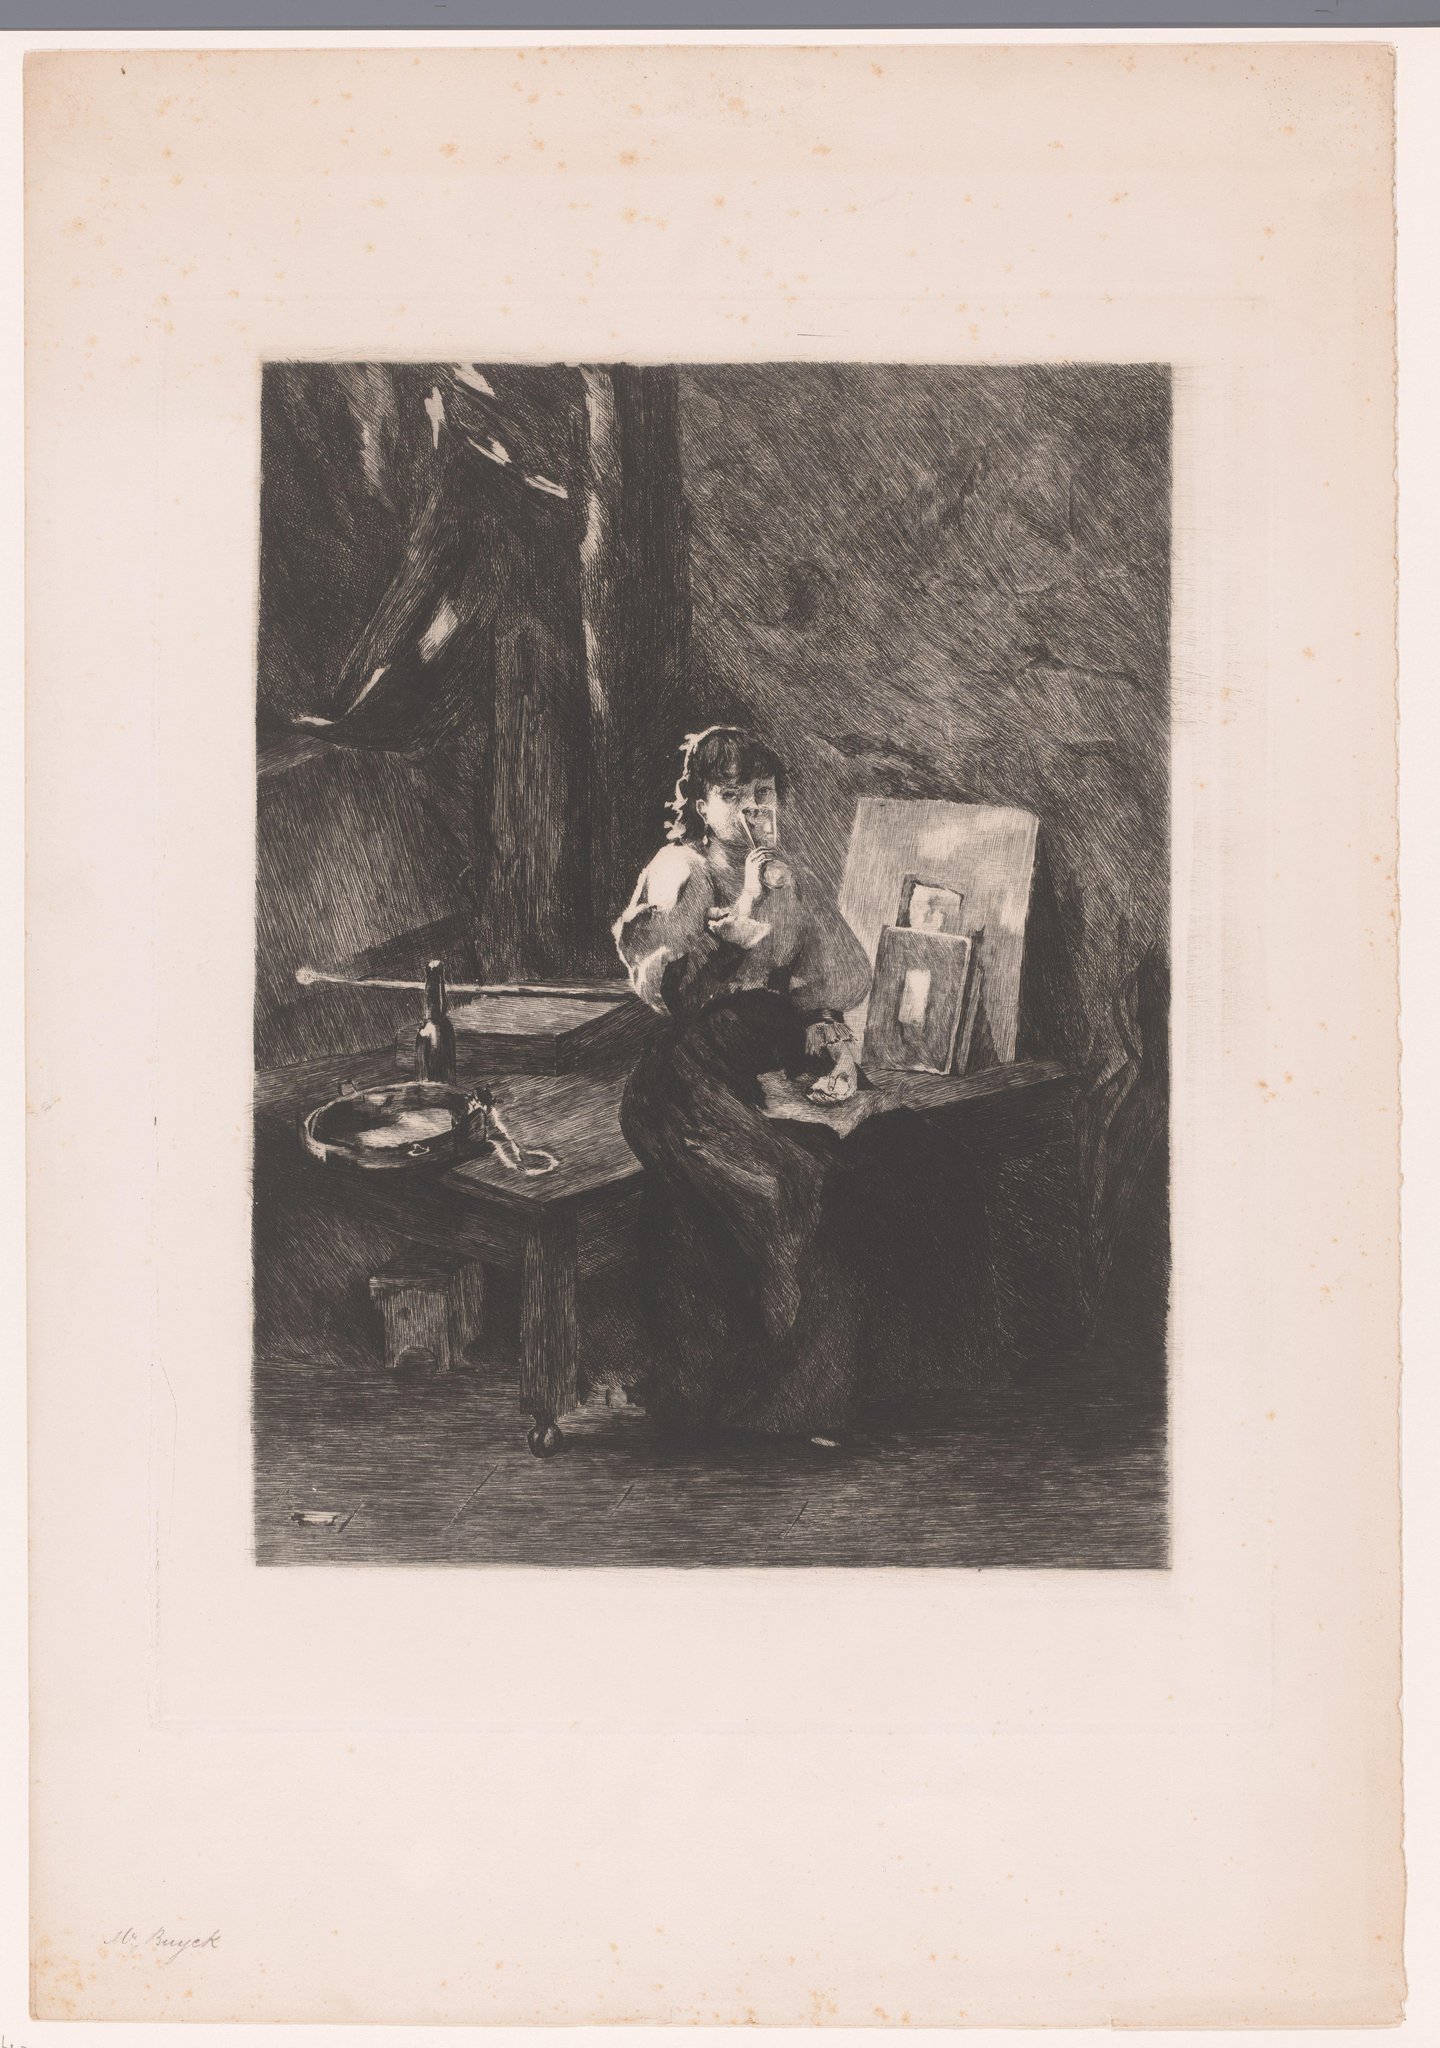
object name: print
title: Dame drinkt in een atelier uit een glas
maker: florimond buyck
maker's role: print maker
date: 1870-1909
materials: paper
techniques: drypoint, etching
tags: bottle of wine, drinking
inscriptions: collector's mark: Lugt 2228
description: Sterfdatum prentmaker onbekend. Derhalve is voor bepaling van de rechten van dit object de verwervingsdatum aangehouden.